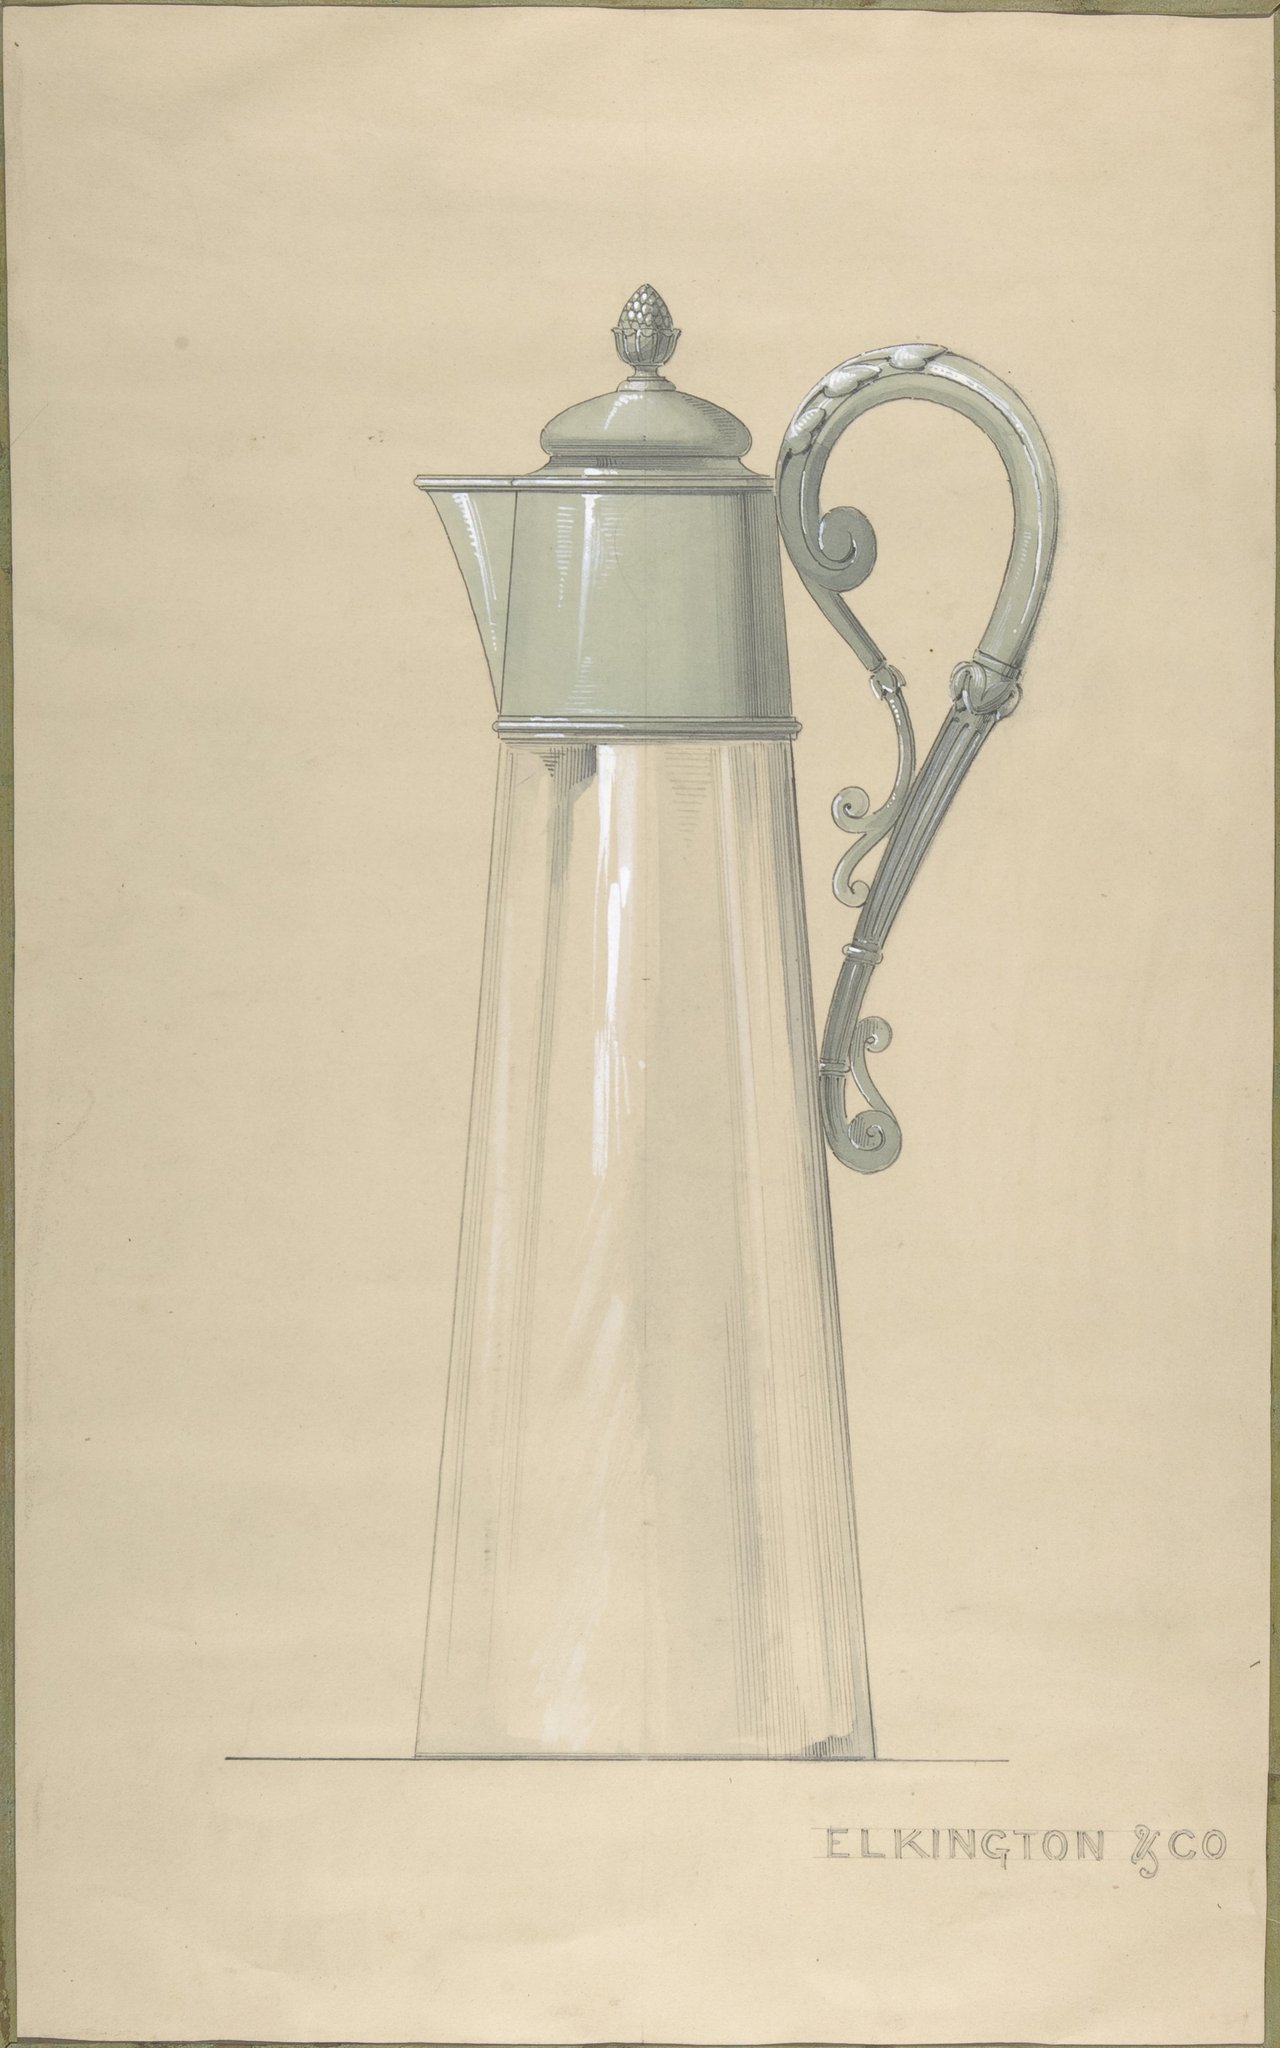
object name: drawing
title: Design for a Lidded Crystal and Silver-Plated Water Pitcher or Claret Jug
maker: elkington & co.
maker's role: manufacturer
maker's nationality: british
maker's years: 1829-1963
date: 1890-1910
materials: gouache, watercolor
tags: pitchers